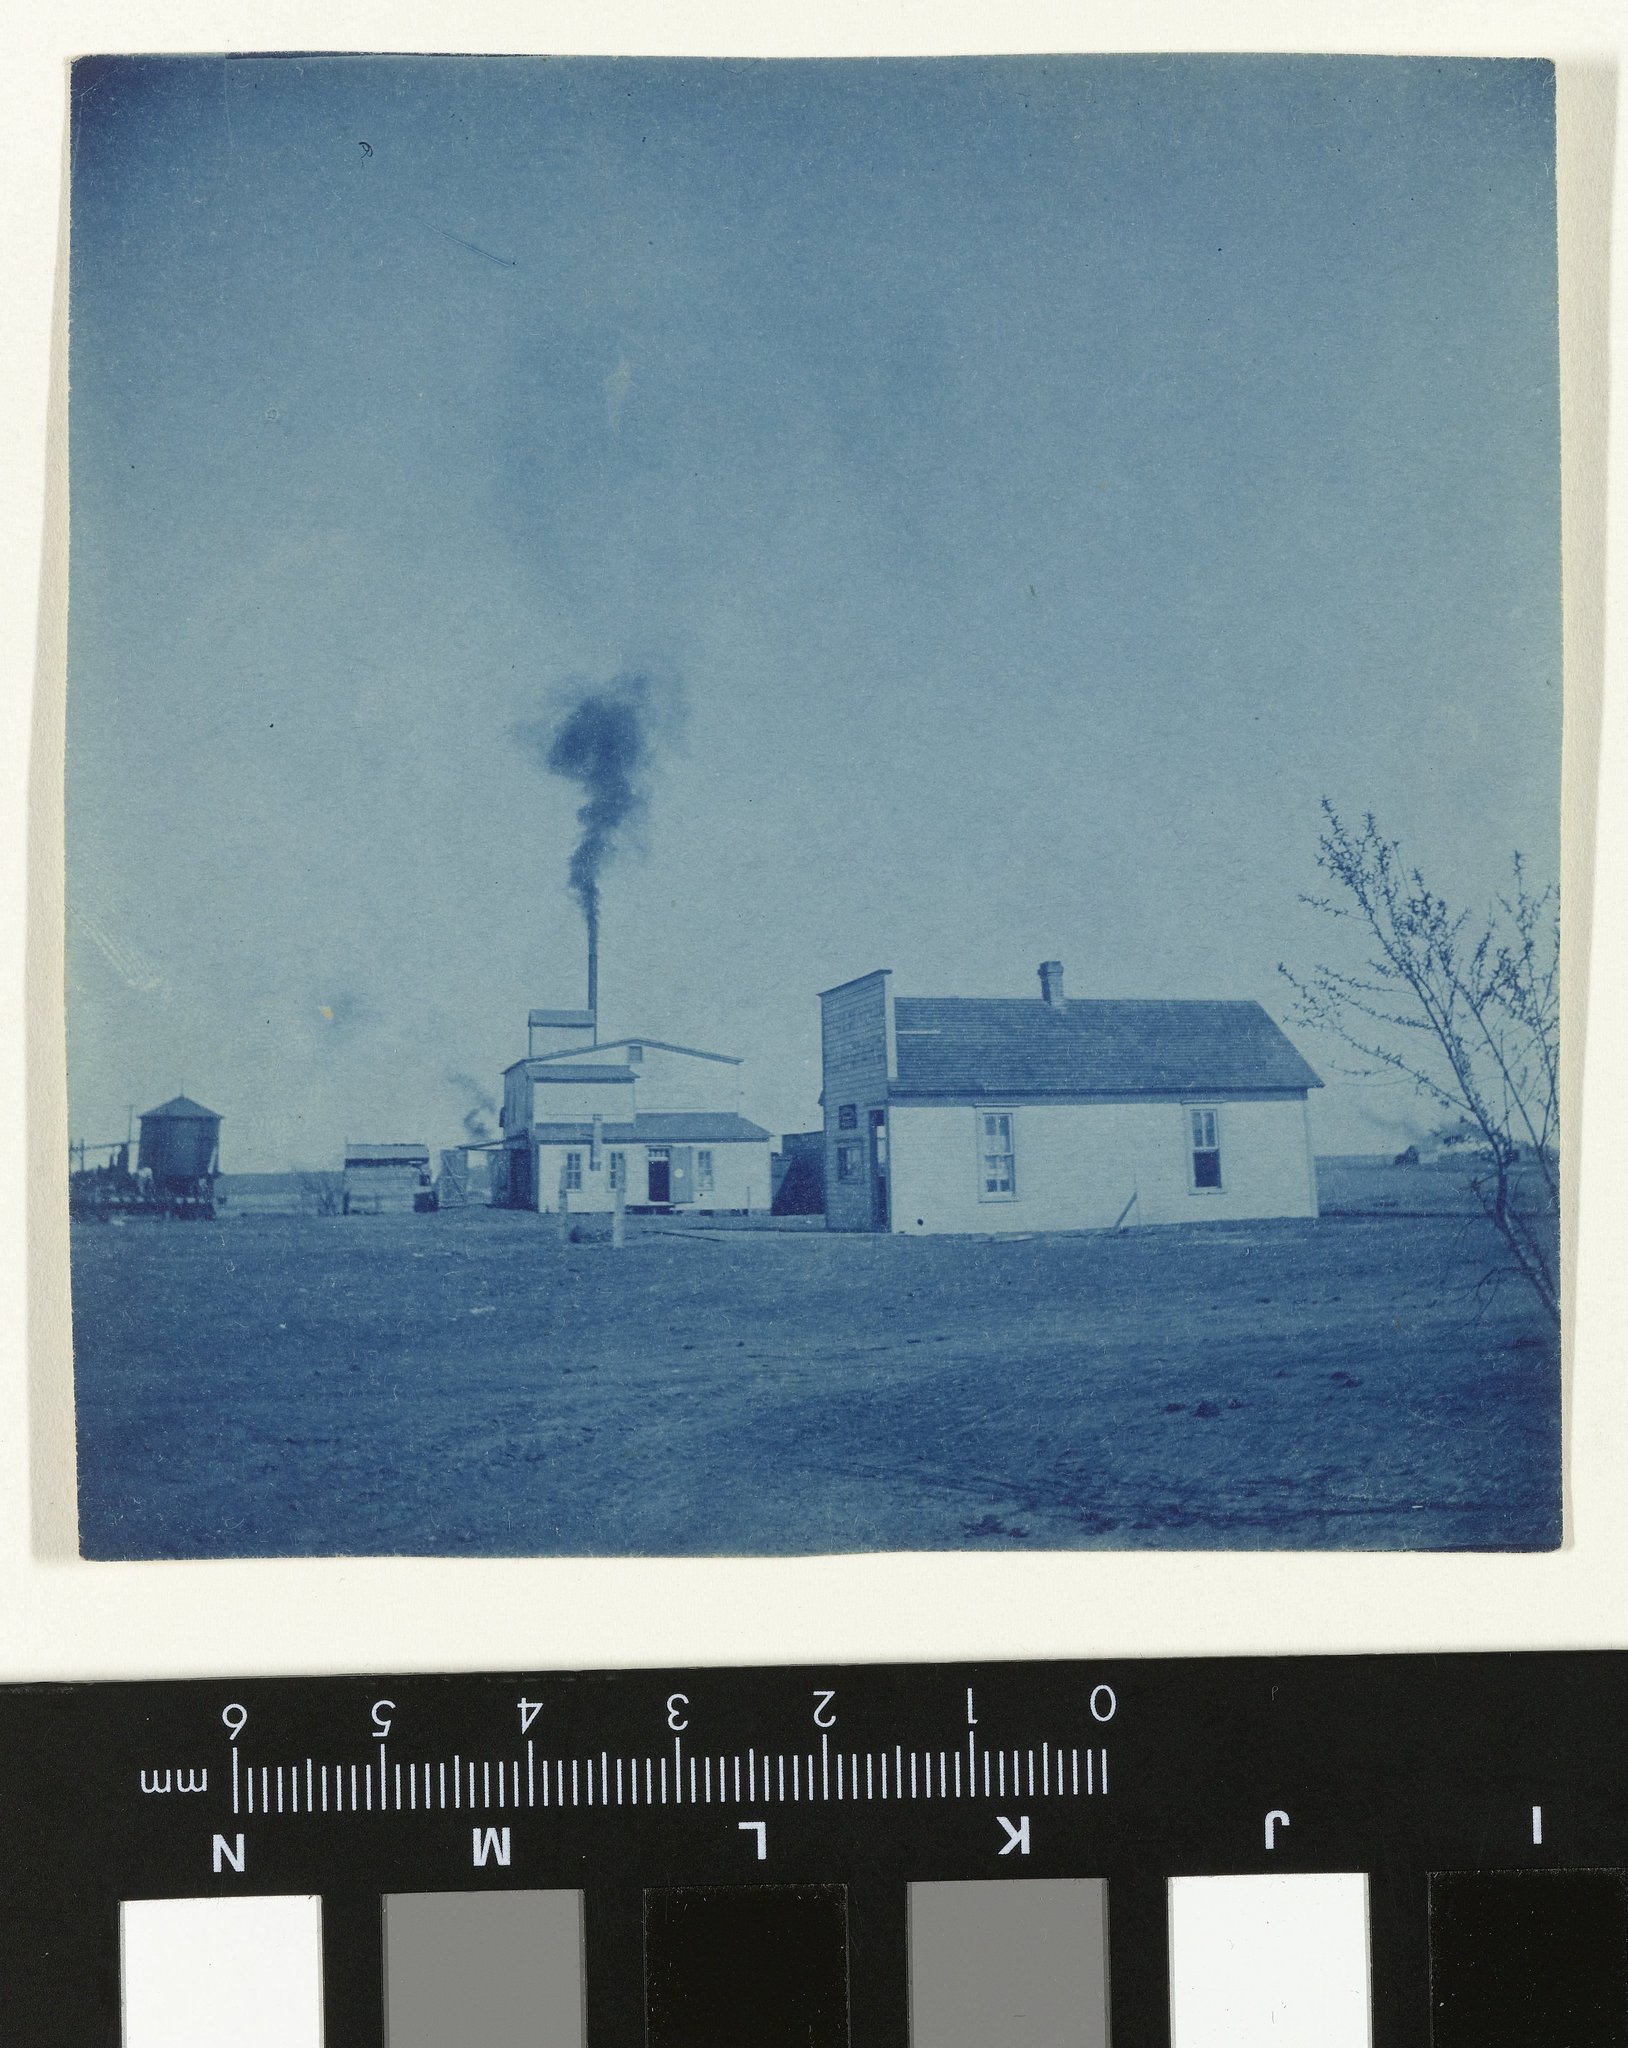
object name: photograph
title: Kantoor en molen van de Yukon MTY Company, Yukon, Oklahoma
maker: Anonymous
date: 1900-1910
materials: paper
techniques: cyanotype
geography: yukon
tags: factory in landscape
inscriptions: annotation: ‘Office + Mill / Yukon MTY [?] Co’